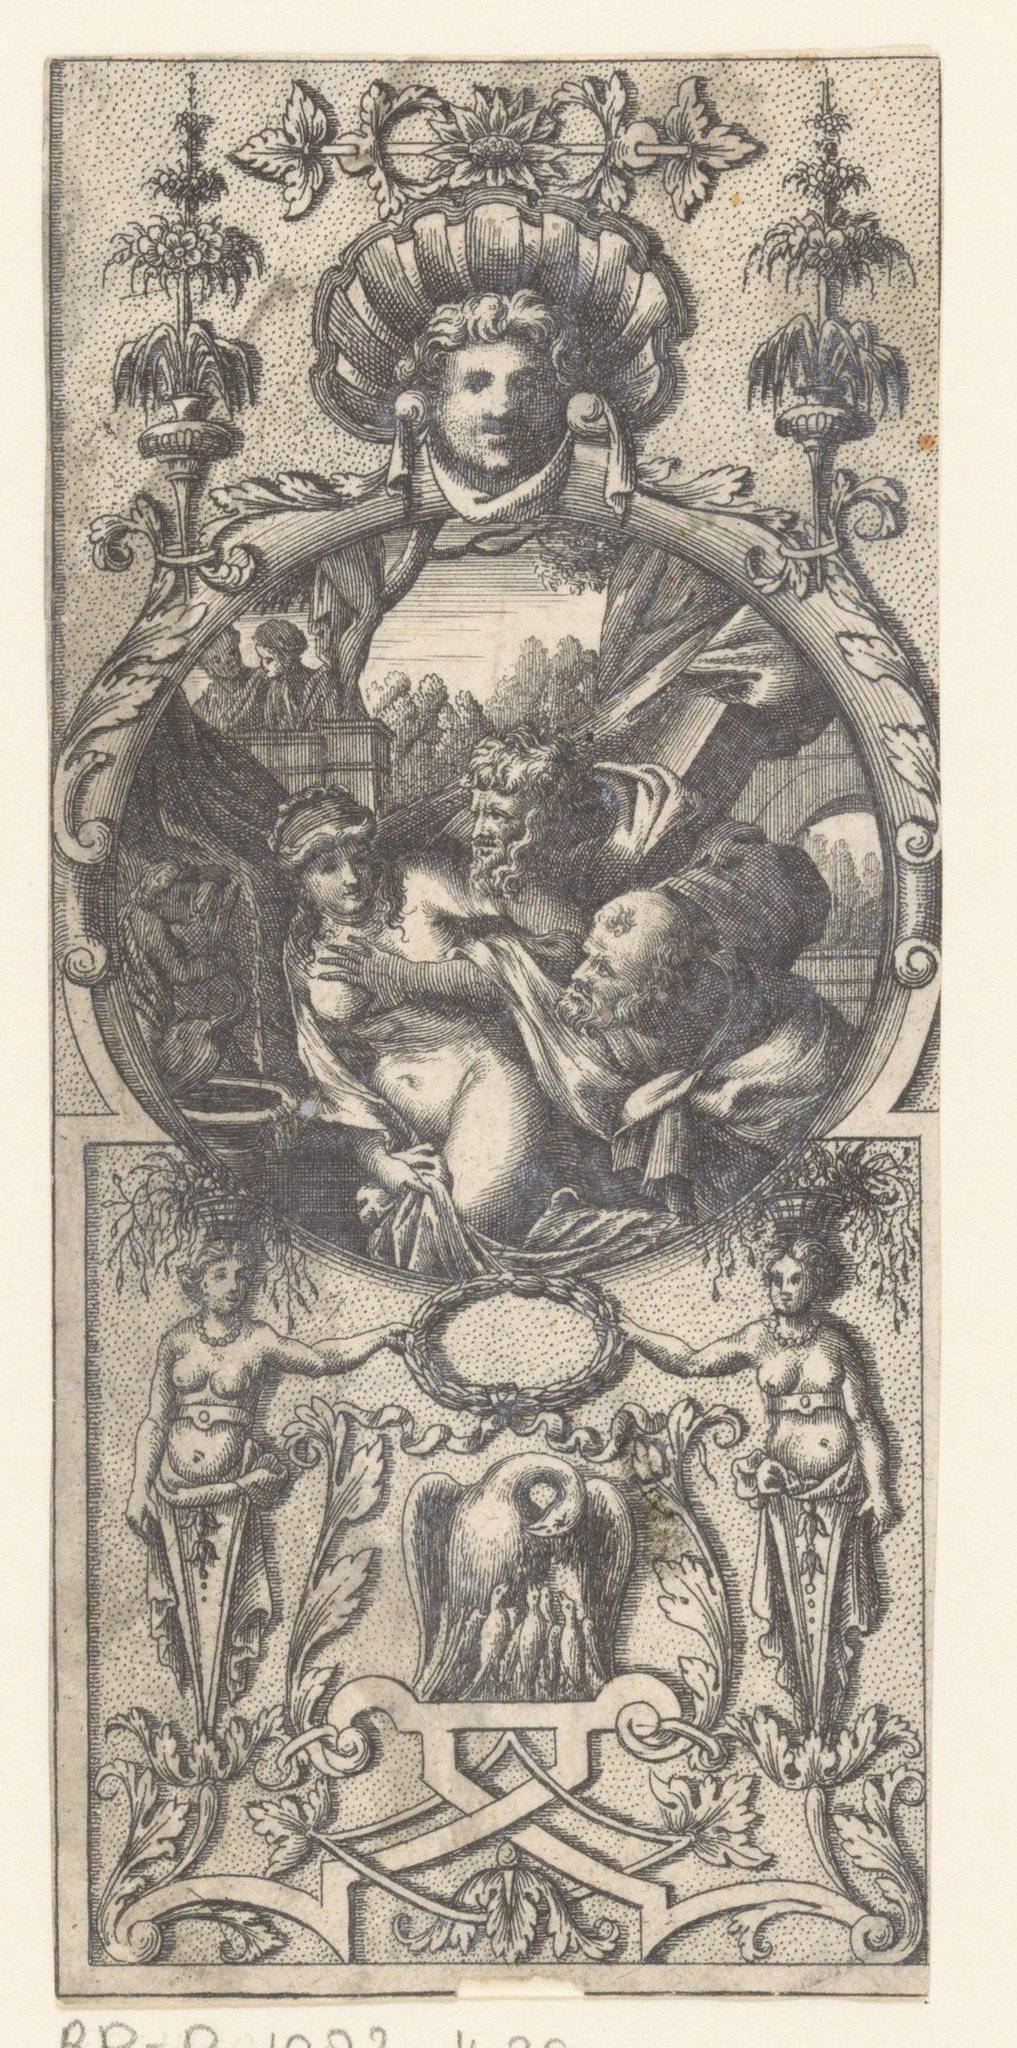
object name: ornament print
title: Susanna en de ouderlingen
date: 1631-1699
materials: paper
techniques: engraving, etching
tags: susanna bathing, usually in or near a fountain and sometimes accompanied by two female servants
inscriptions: collector's mark: Lugt 2228, collector's mark: Lugt 2760, inscription: ‘sot.3.11.66’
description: Rond medaillon met Susanna en de ouderlingen. Rondom een groteske omlijsting. Aan de onderzijde twee termen met een krans boven een pelikaan die zijn jongen voedt.